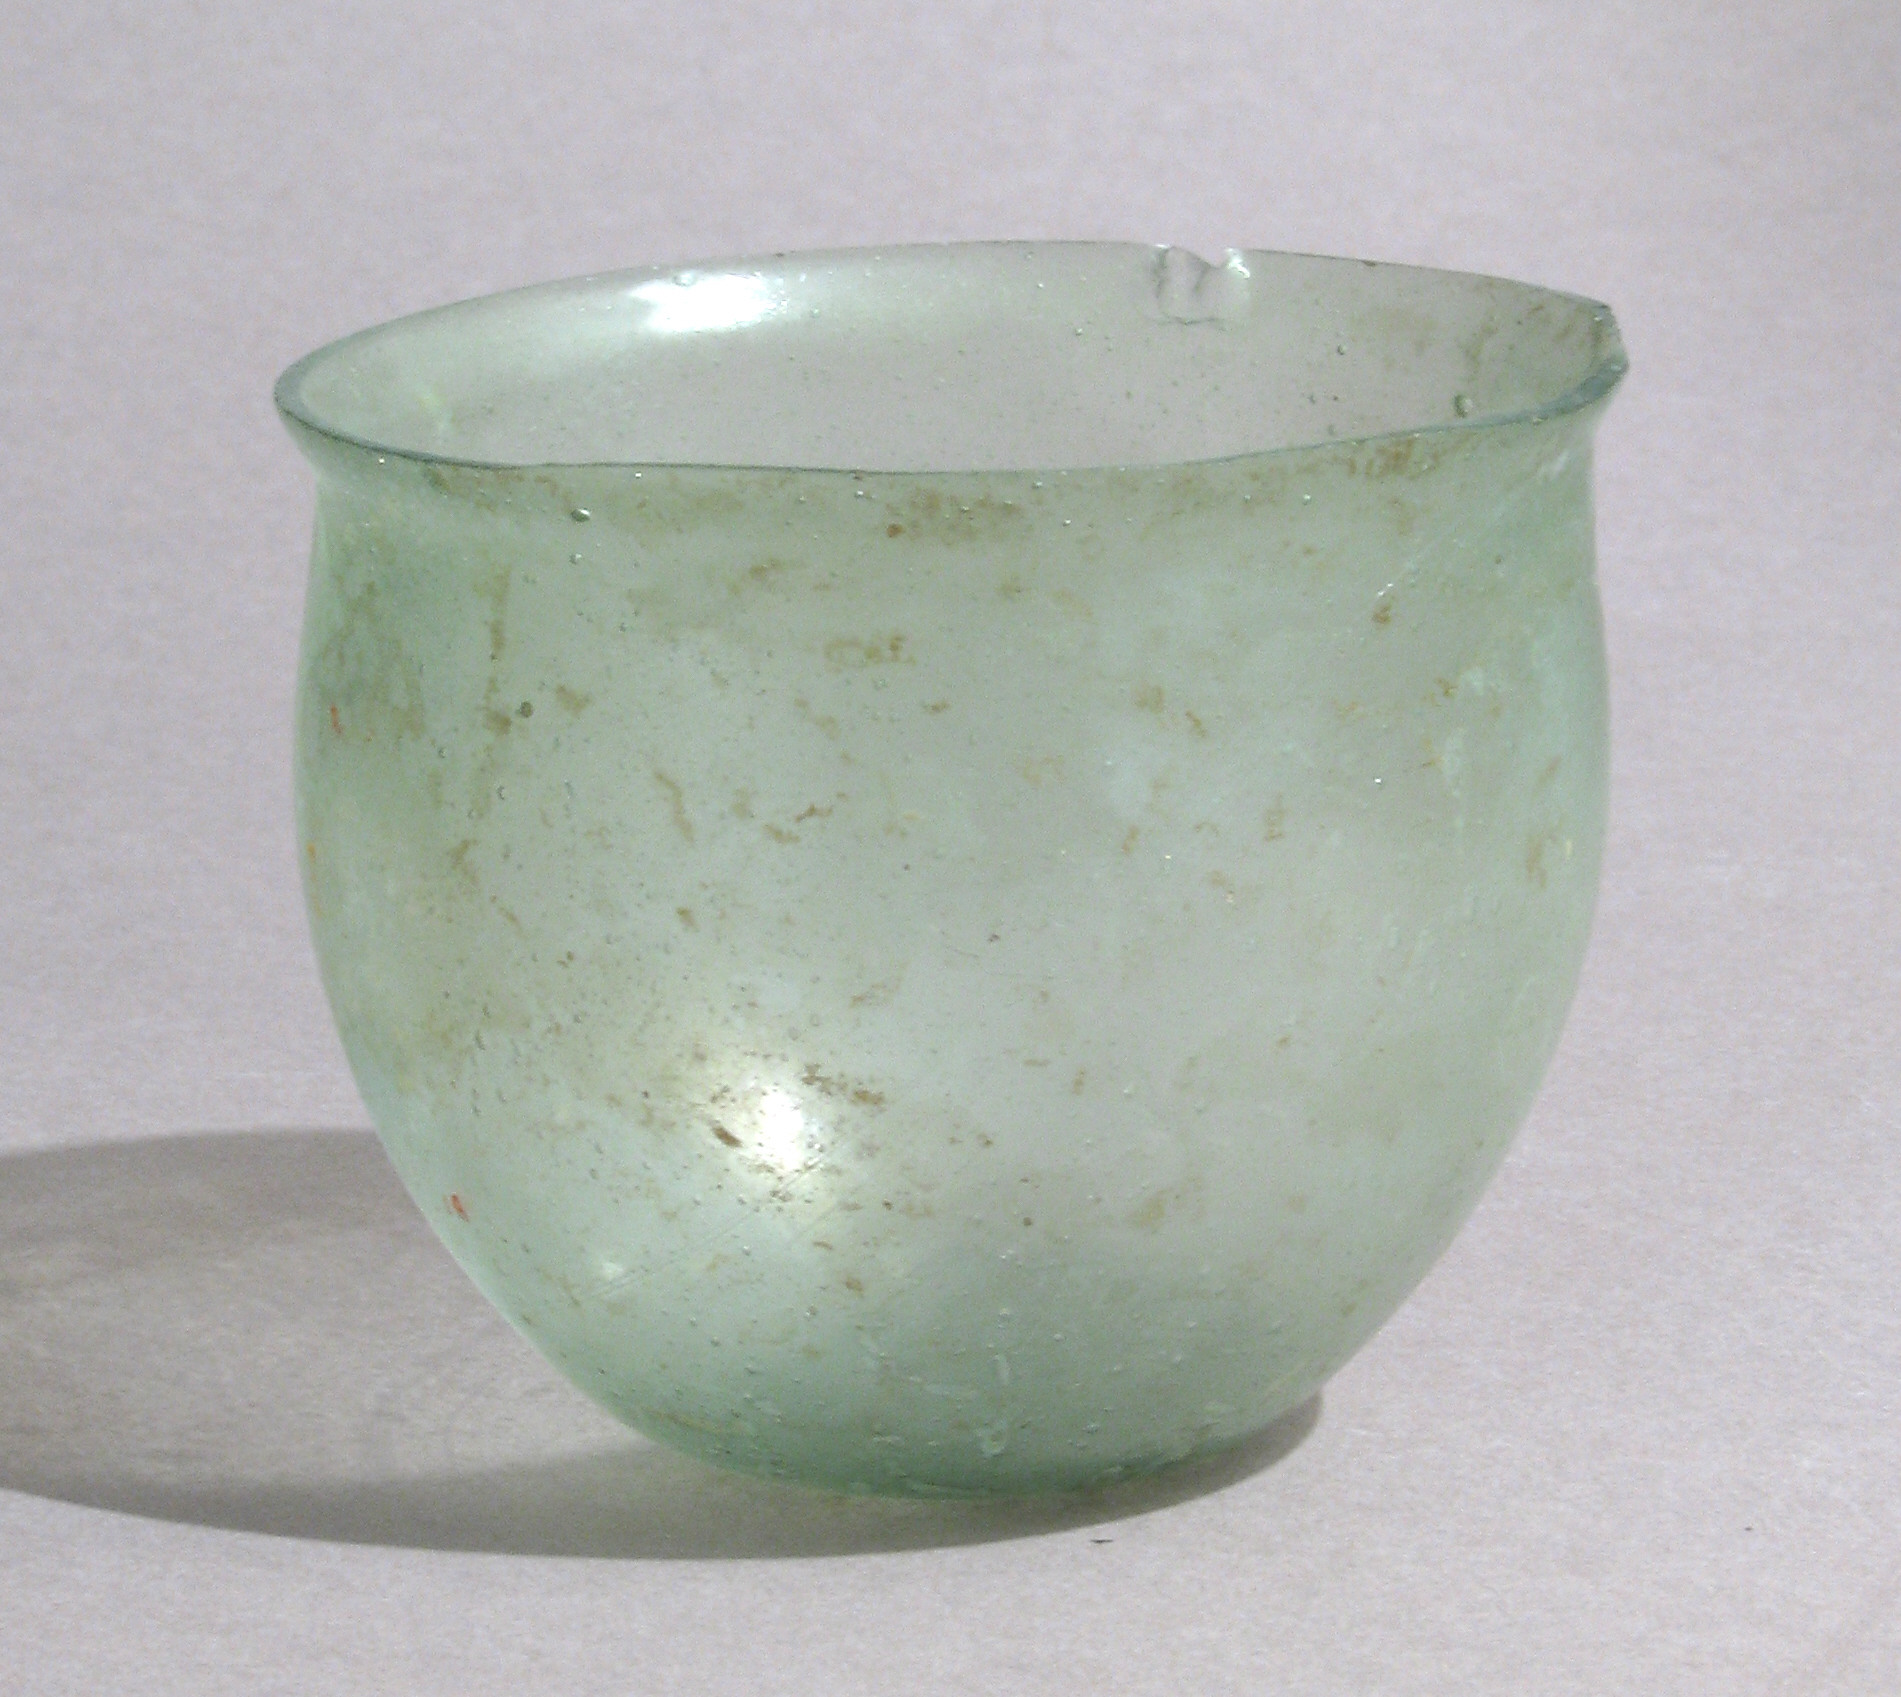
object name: bowl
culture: roman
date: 367-433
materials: glass